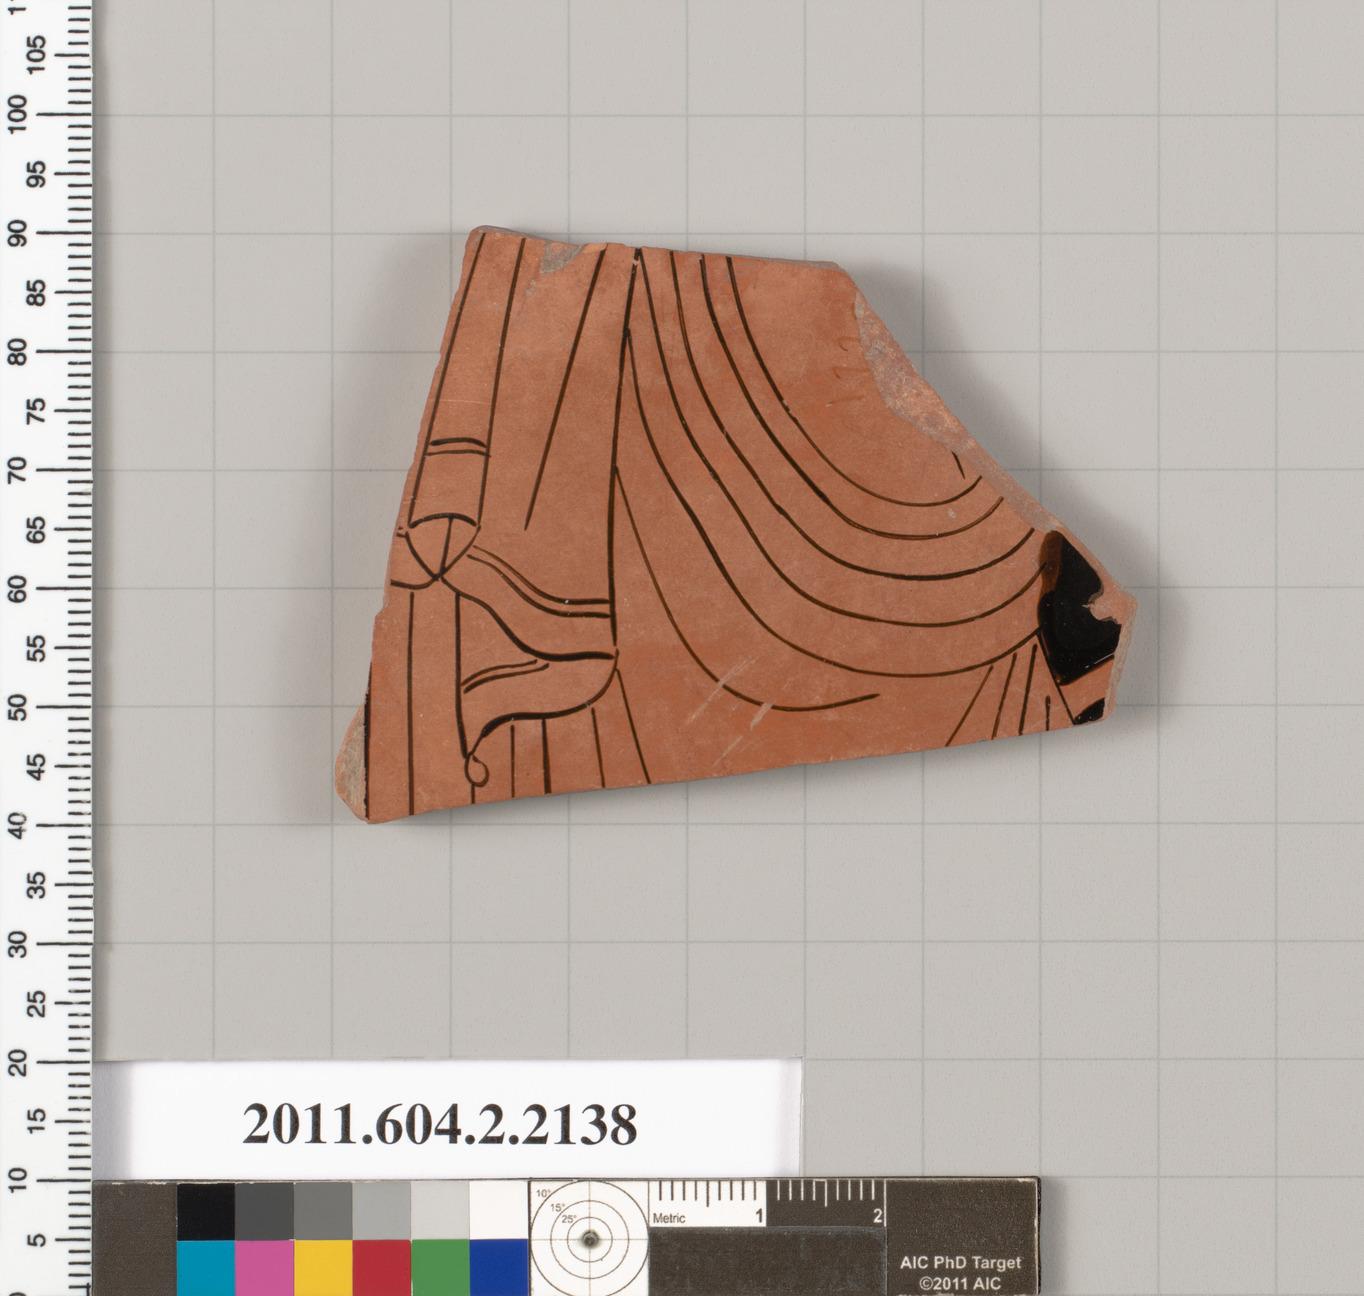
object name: pot fragment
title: Terracotta fragment of a pot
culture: greek, attic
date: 490-470 BCE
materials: terracotta